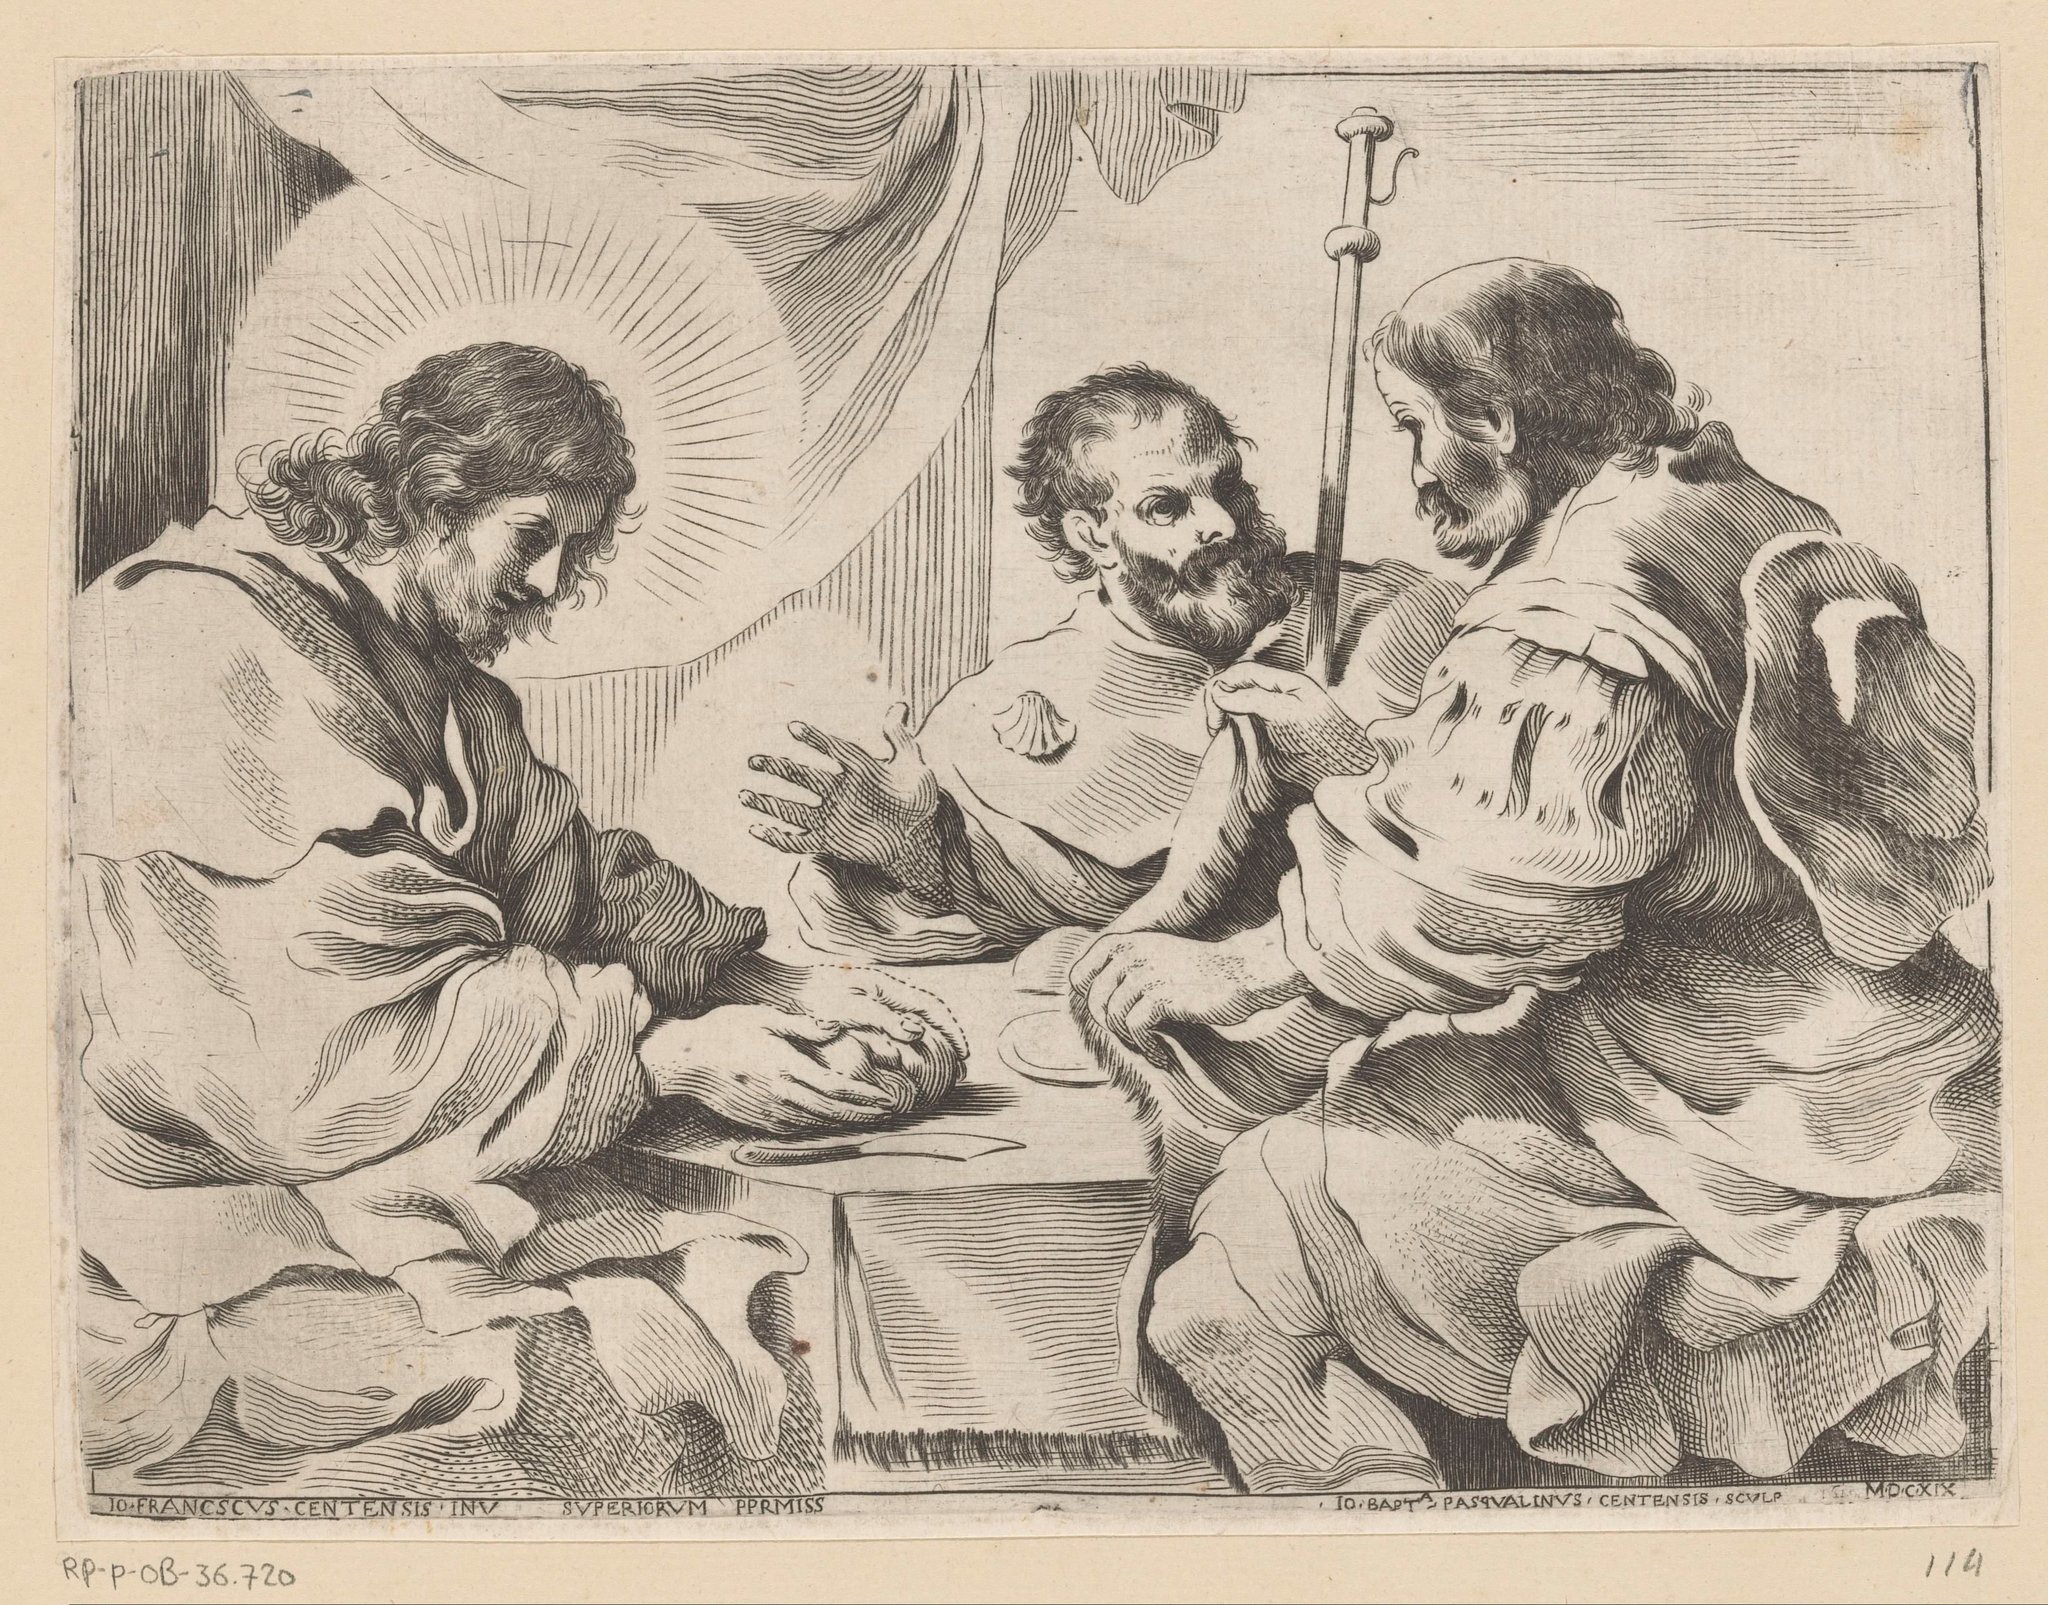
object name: print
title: Maaltijd in Emmaüs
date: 1619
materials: paper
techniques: engraving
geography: italy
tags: the supper at emmaus: christ is recognized while blessing or breaking the bread, pilgrim's dress and attributes, e.g. flask, hat, mantle, staff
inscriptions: collector's mark: Lugt 240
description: Christus aan tafel met Kleopas en mogelijk Petrus, gekleed als pelgrims, die Christus op de weg naar Emmaüs tegenkwam. Terwijl Christus het brood breekt, wordt hij door de twee discipelen herkend.